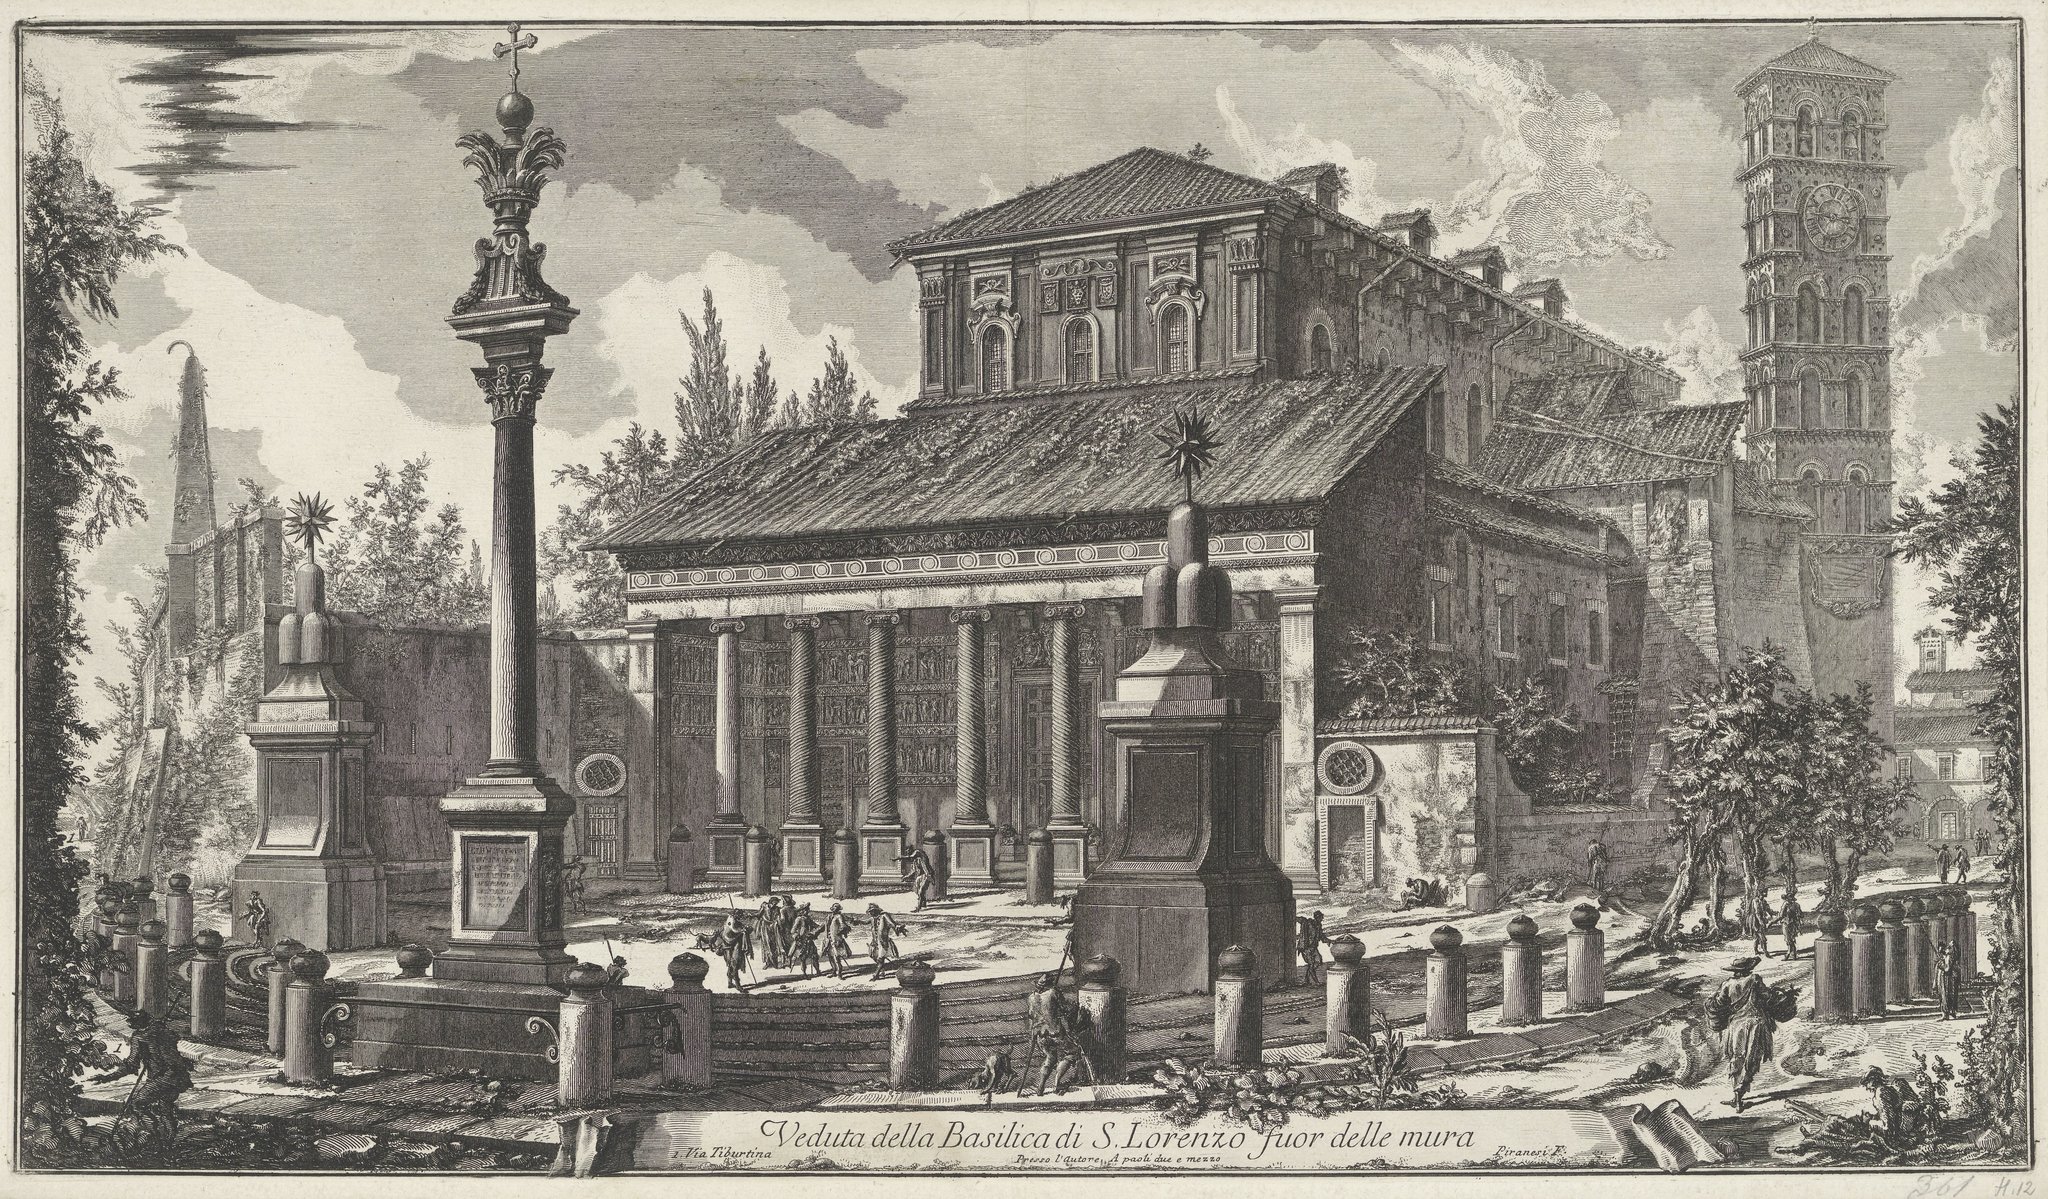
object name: print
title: Gezichten op Rome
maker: giovanni battista piranesi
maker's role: designer, draughtsman, print maker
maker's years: 1720-1778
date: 1748-1778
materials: paper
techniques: etching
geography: rome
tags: church (exterior), roman catholic church, rome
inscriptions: collector's mark: Lugt 2228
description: Deze prent maakt deel uit van de serie 'Vedute di Roma'. Piranesi werkte aan deze 135 platen tellende serie tussen 1748 en zijn dood in 1778. Francesco Piranesi voegde later nog twee prenten toe aan de reeks van zijn vader.